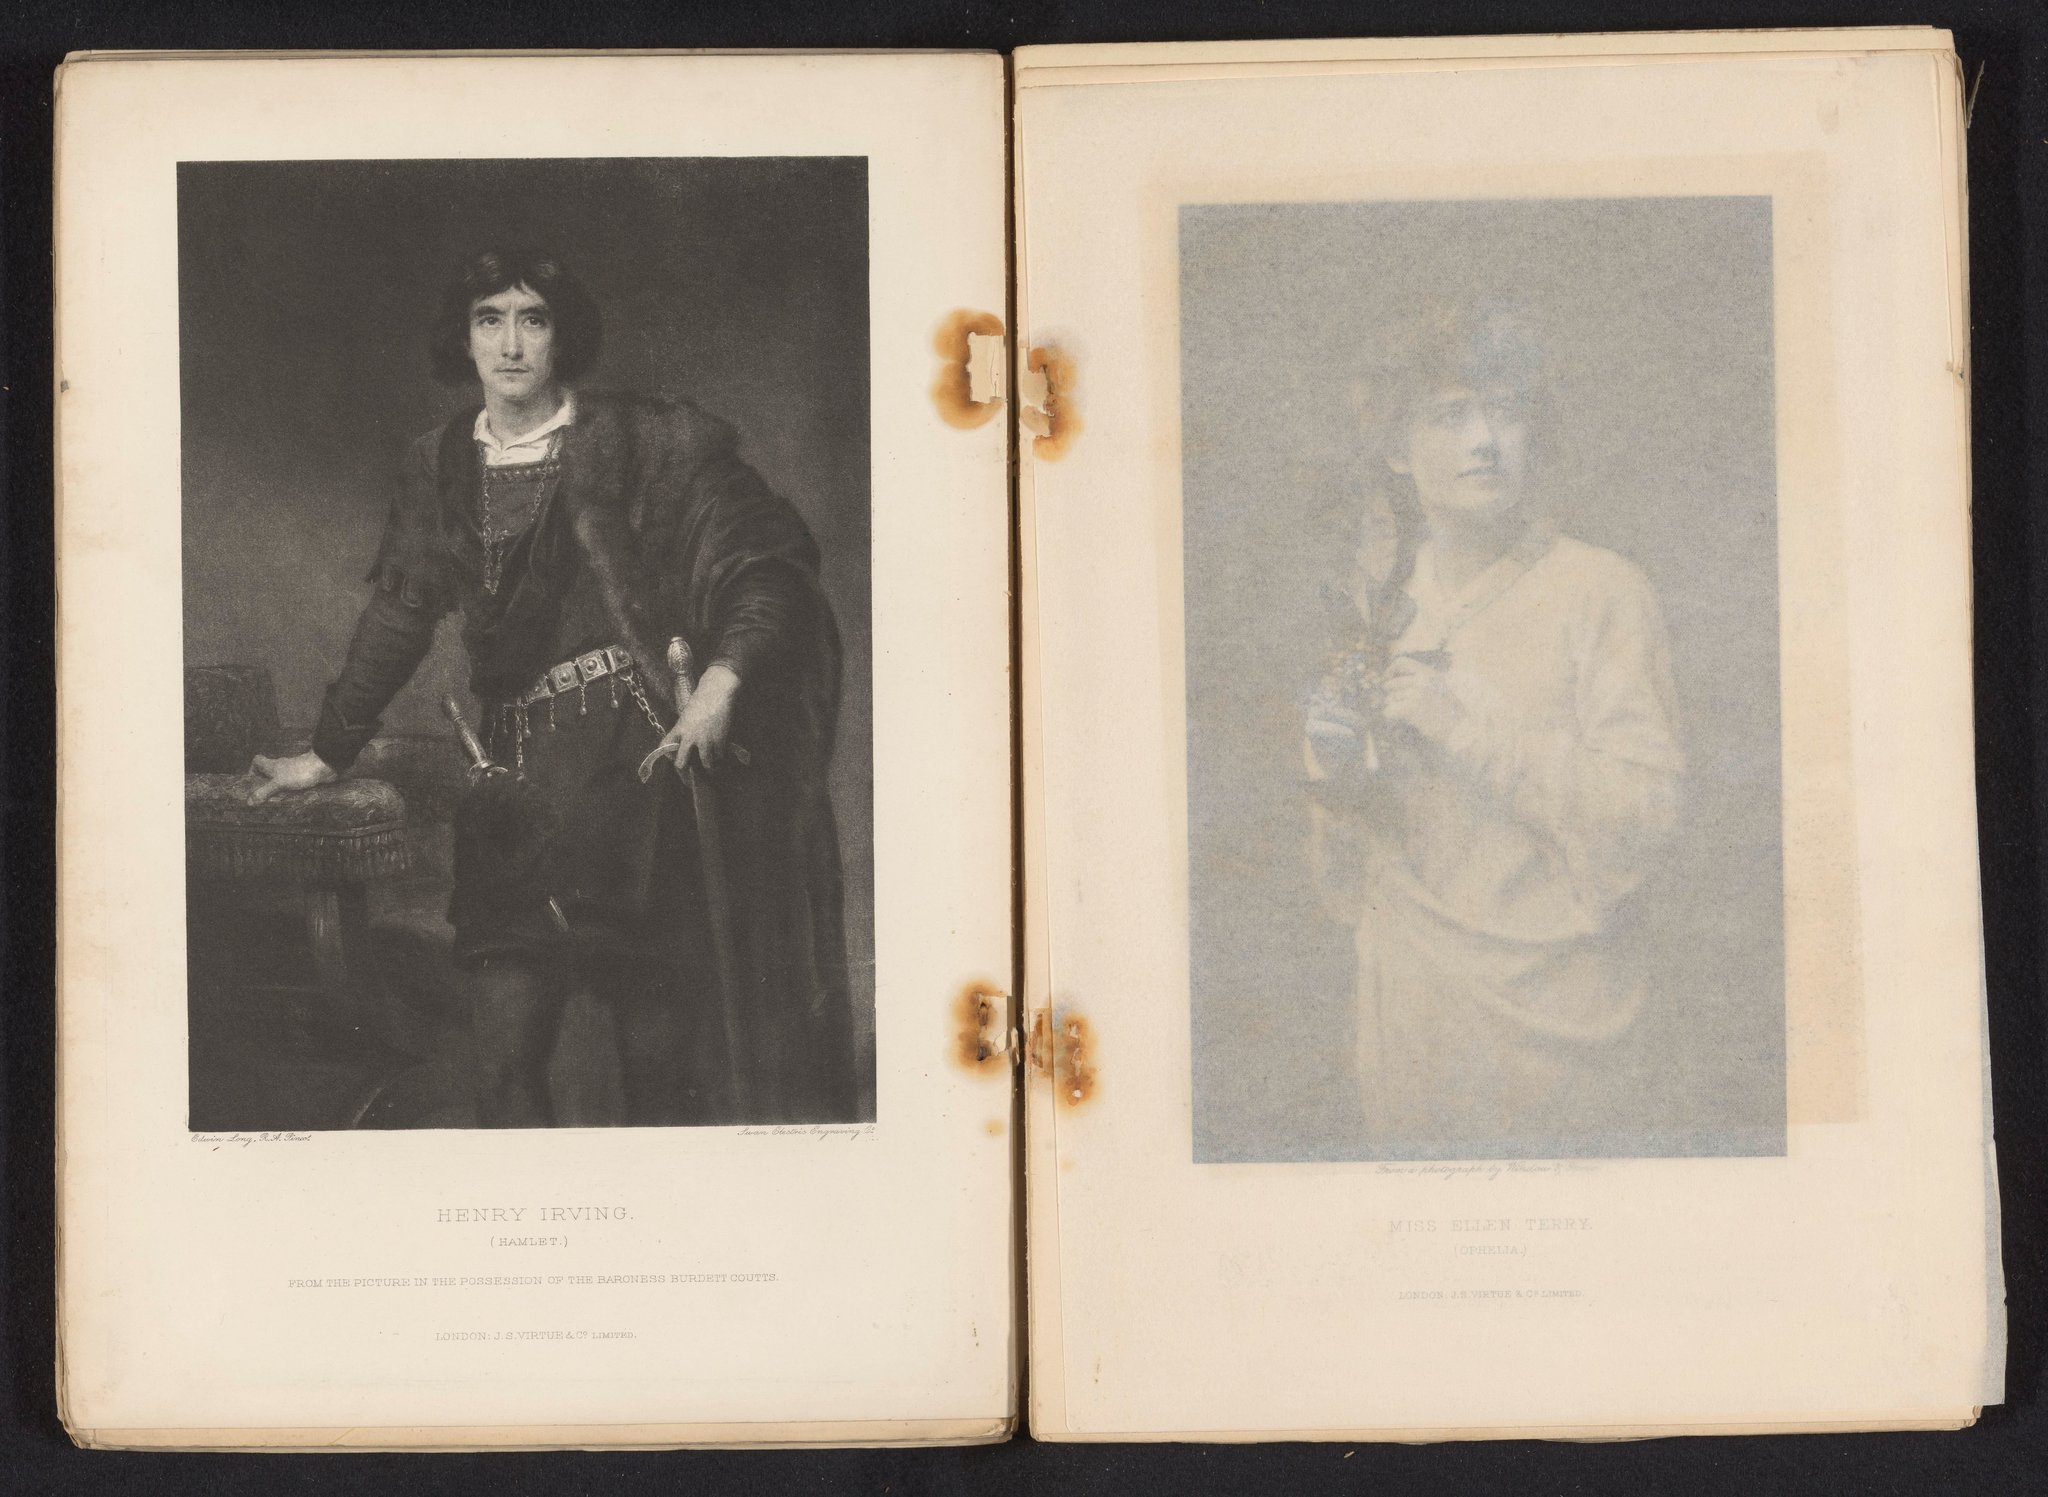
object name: reproduction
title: Henry Irving (Hamlet)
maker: edwin long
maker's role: painter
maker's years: 1829-1891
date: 1880-1890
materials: paper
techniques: photoaquatint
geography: london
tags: portrait of actor, actress